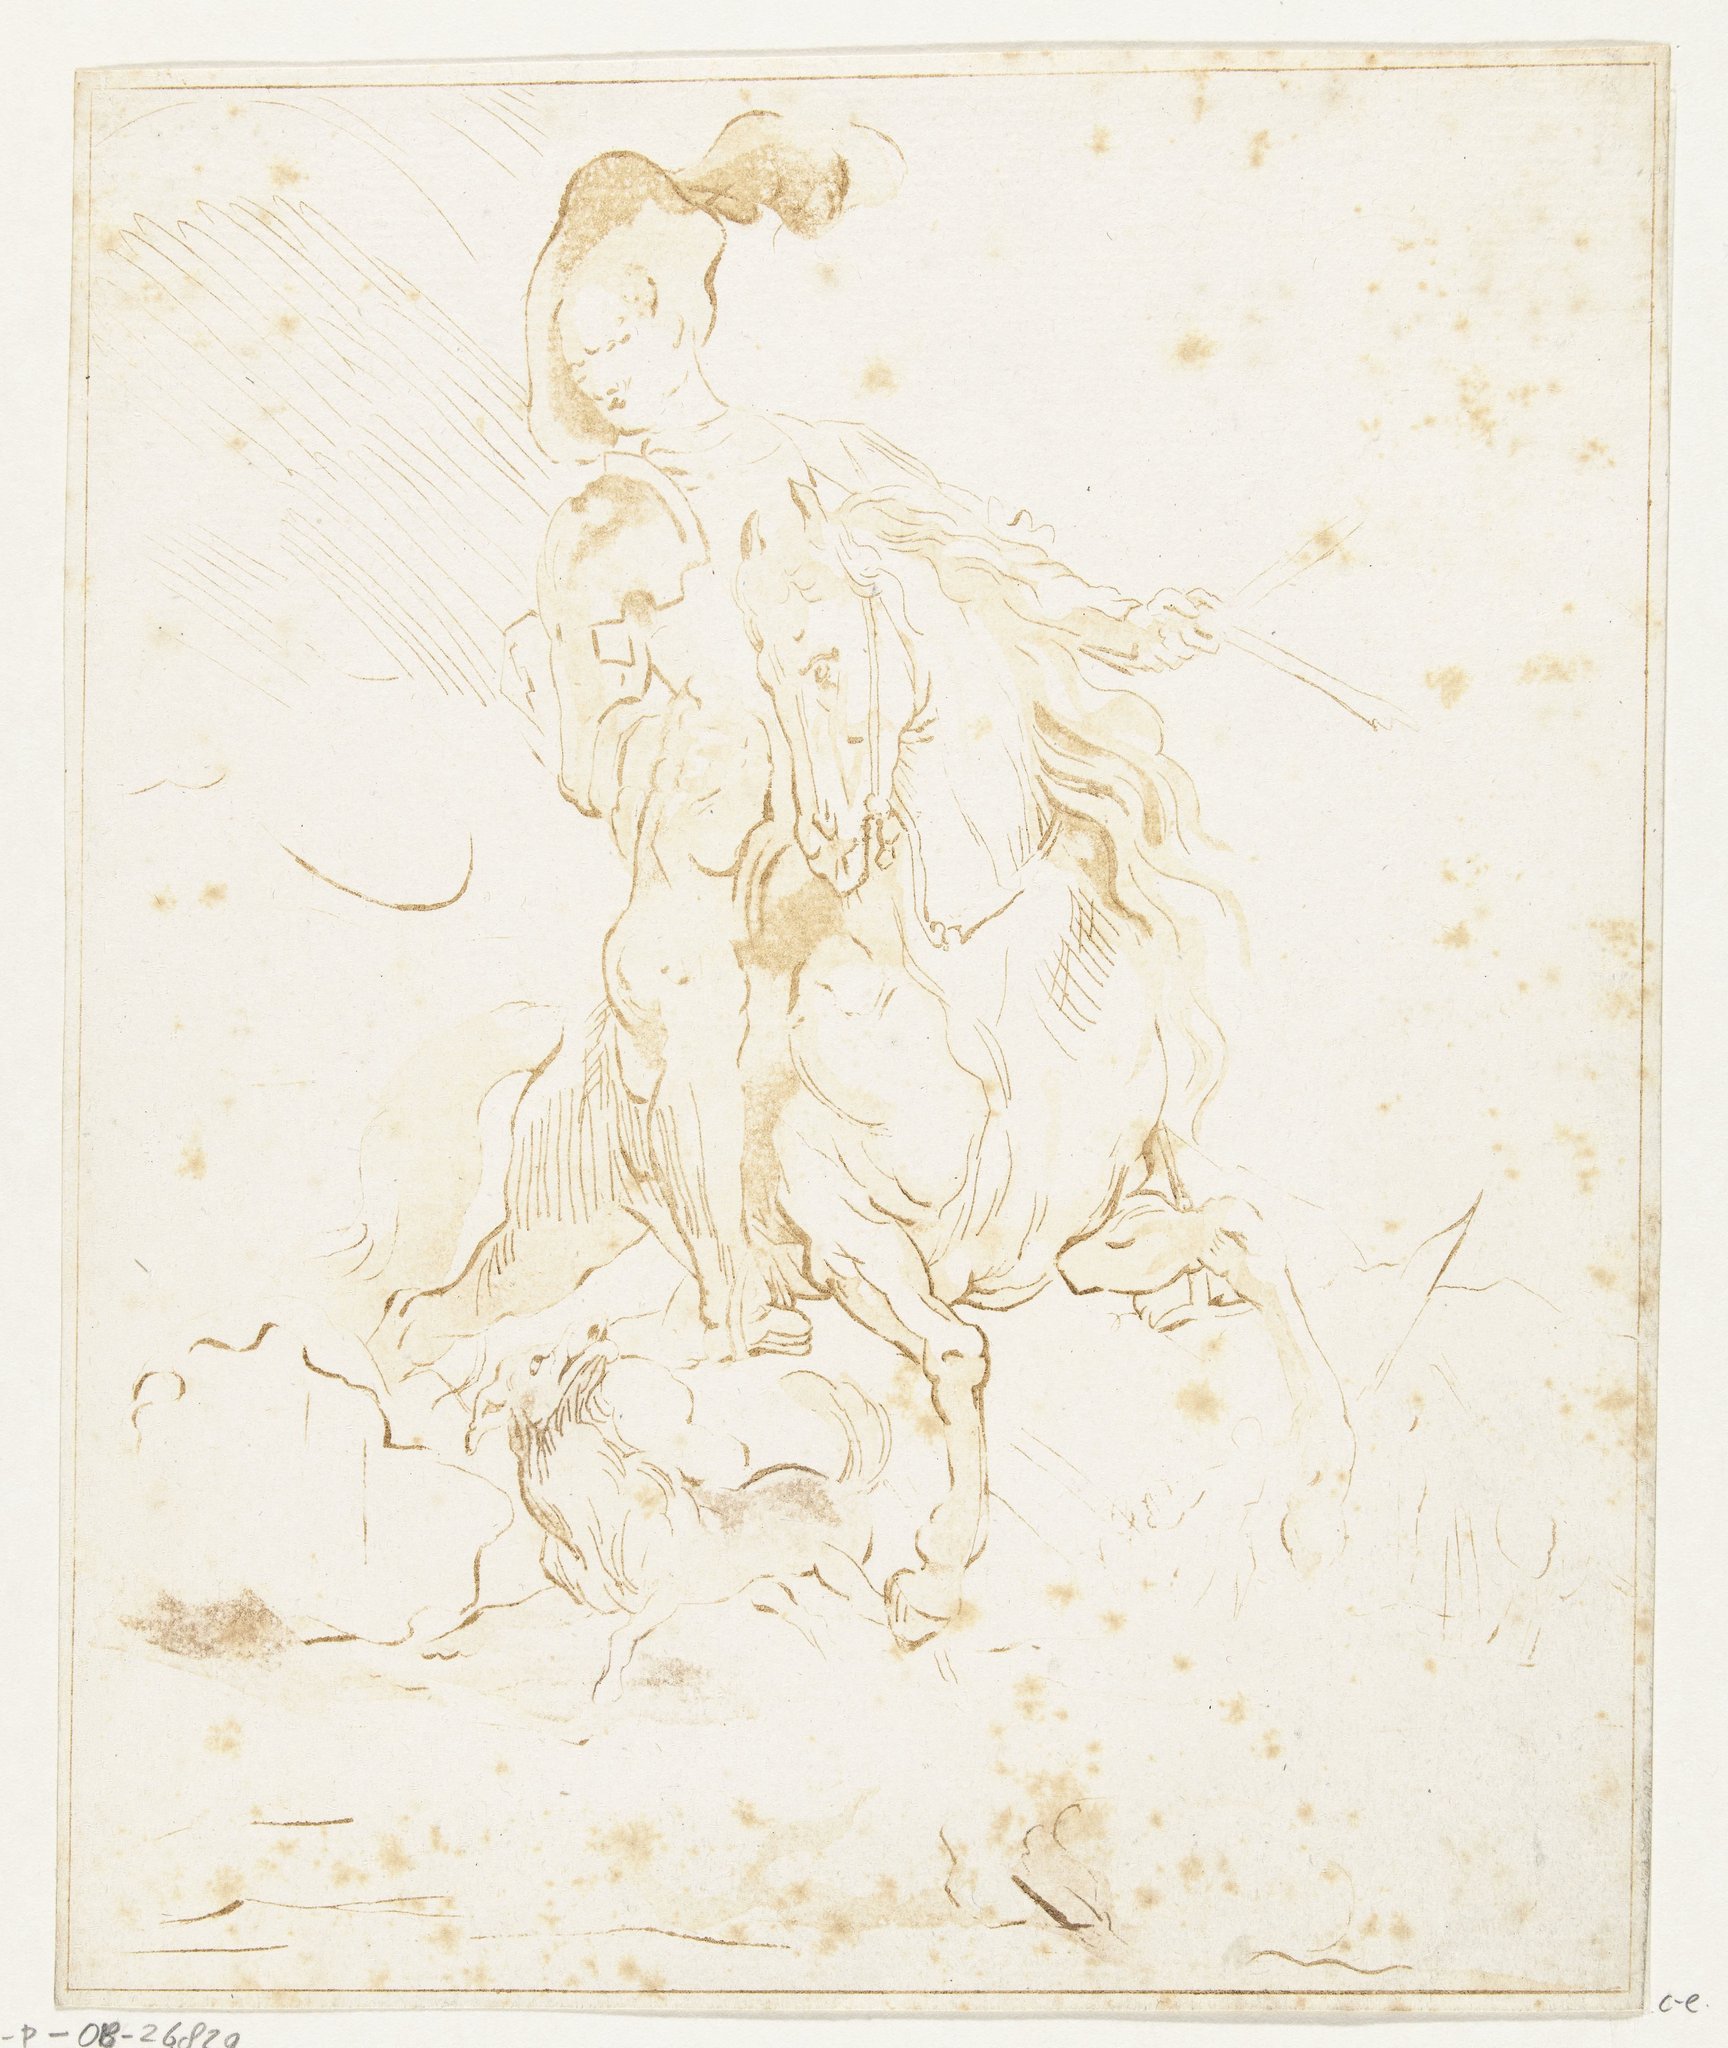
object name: print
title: Ruiter met hond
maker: anthonie van den bos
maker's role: draughtsman, print maker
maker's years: 1763-1838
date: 1778-1838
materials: paper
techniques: printing, printmaking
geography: netherlands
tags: riding a horse, ass, or mule; rider, horseman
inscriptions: collector's mark: Lugt 2228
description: Een soldaat met wapenrusting en een pluim aan zijn hoed, te paard. Een hond loopt tussen de benen van het paard. Op de achtergrond zijn oprukkende soldaten met een vlag schematisch weergegeven.